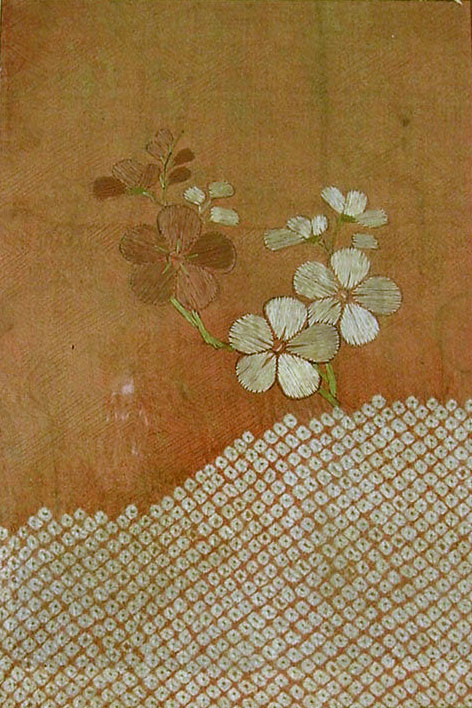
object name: piece from a kosode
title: Piece from a Kosode with Plum Blossoms and Cloud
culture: japanese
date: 1615-1868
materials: silk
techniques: damask, dyeing, embroidery, resist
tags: flowers